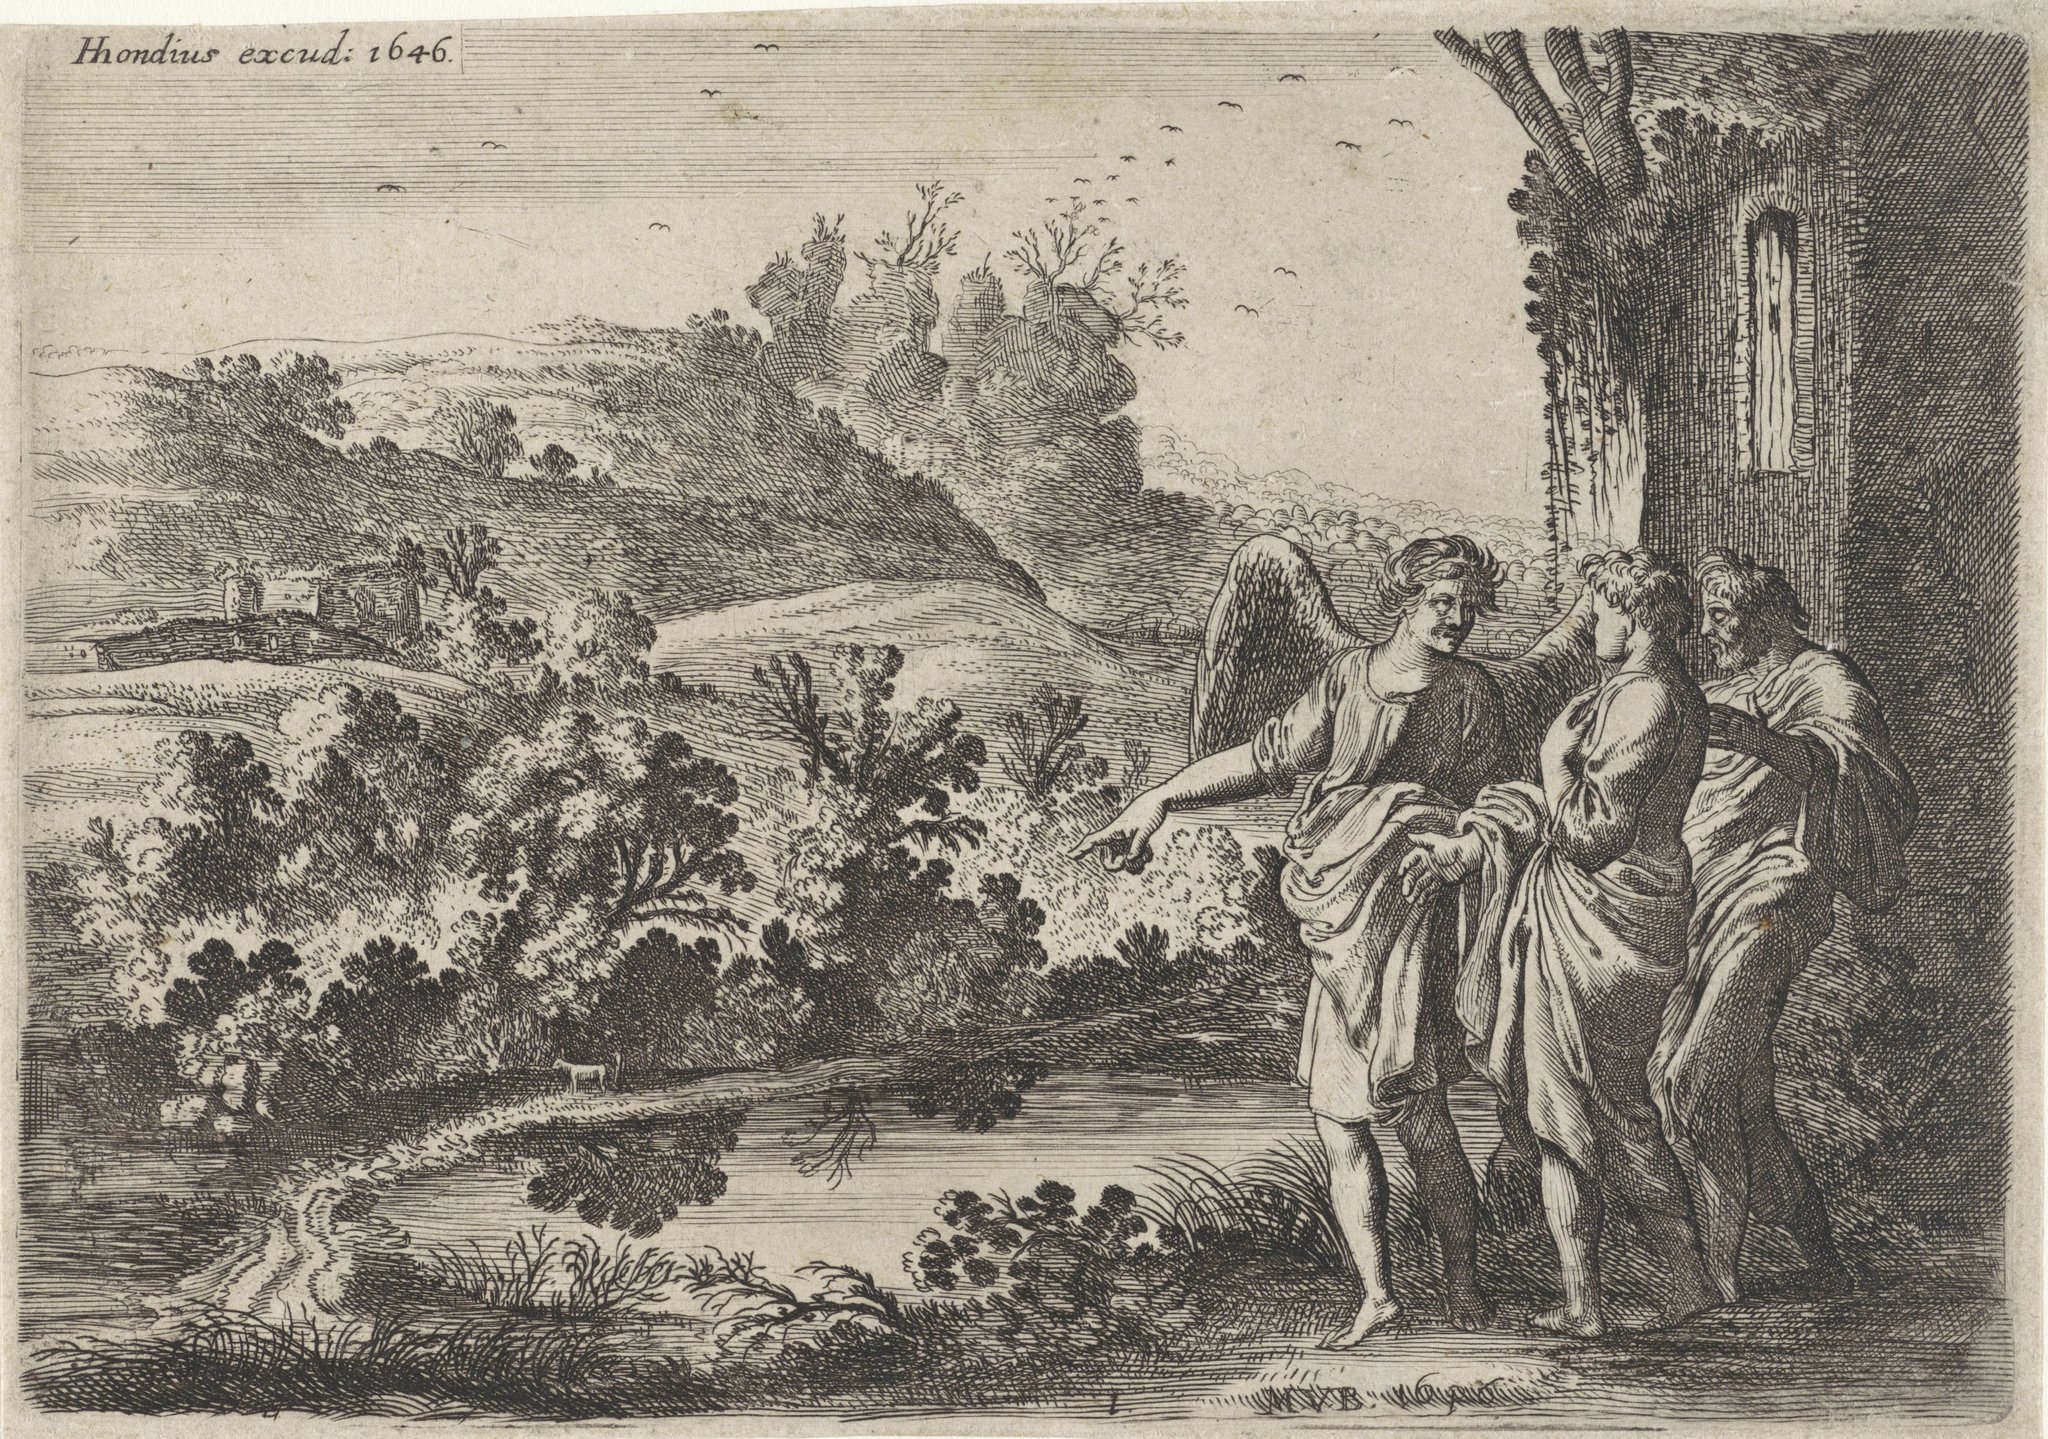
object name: print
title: Tobias, Tobit en de engel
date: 1620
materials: paper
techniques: etching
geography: the hague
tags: tobias and the angel raphael with tobit (and anna)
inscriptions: collector's mark: Lugt 2610, collector's mark: Lugt 2228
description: In een heuvellandschap staat Tobit die zijn zoon Tobias aan de engel toe vertrouwt. Genummerd als 1.